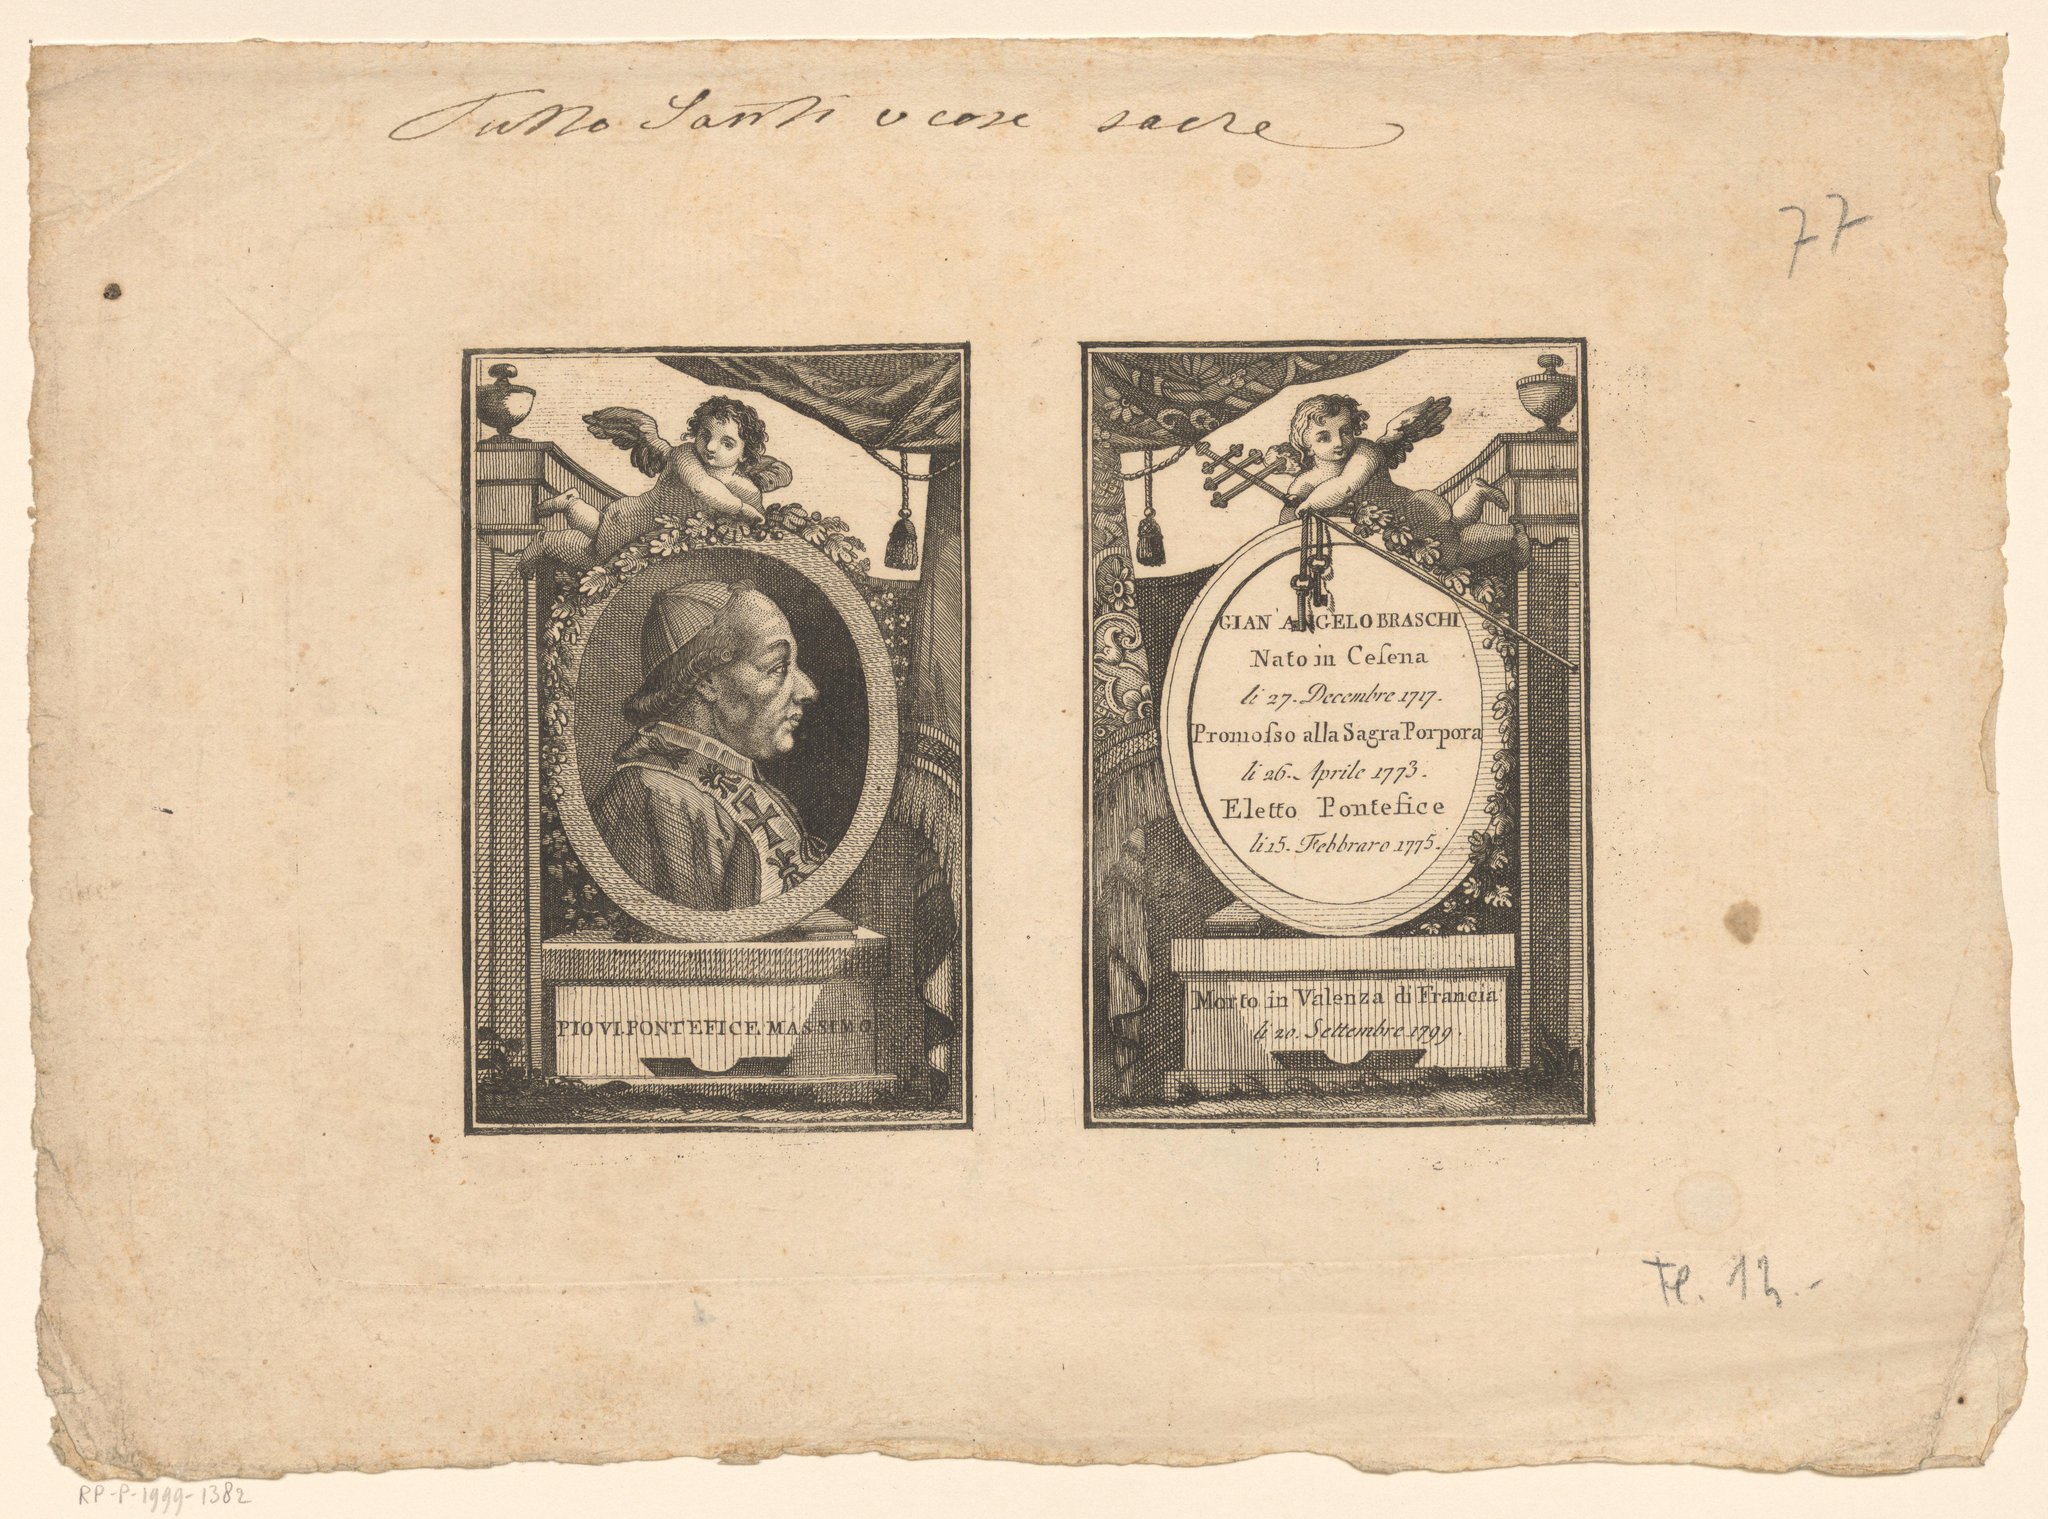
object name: print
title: Portret van paus Pius VI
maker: Anonymous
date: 1800-1849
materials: paper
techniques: engraving, etching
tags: pius vi, historical persons, pope, cupids: 'amores', 'amoretti', 'putti'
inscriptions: collector's mark: Lugt 2228, collector's mark: Lugt 2760, inscription: ‘[...]’